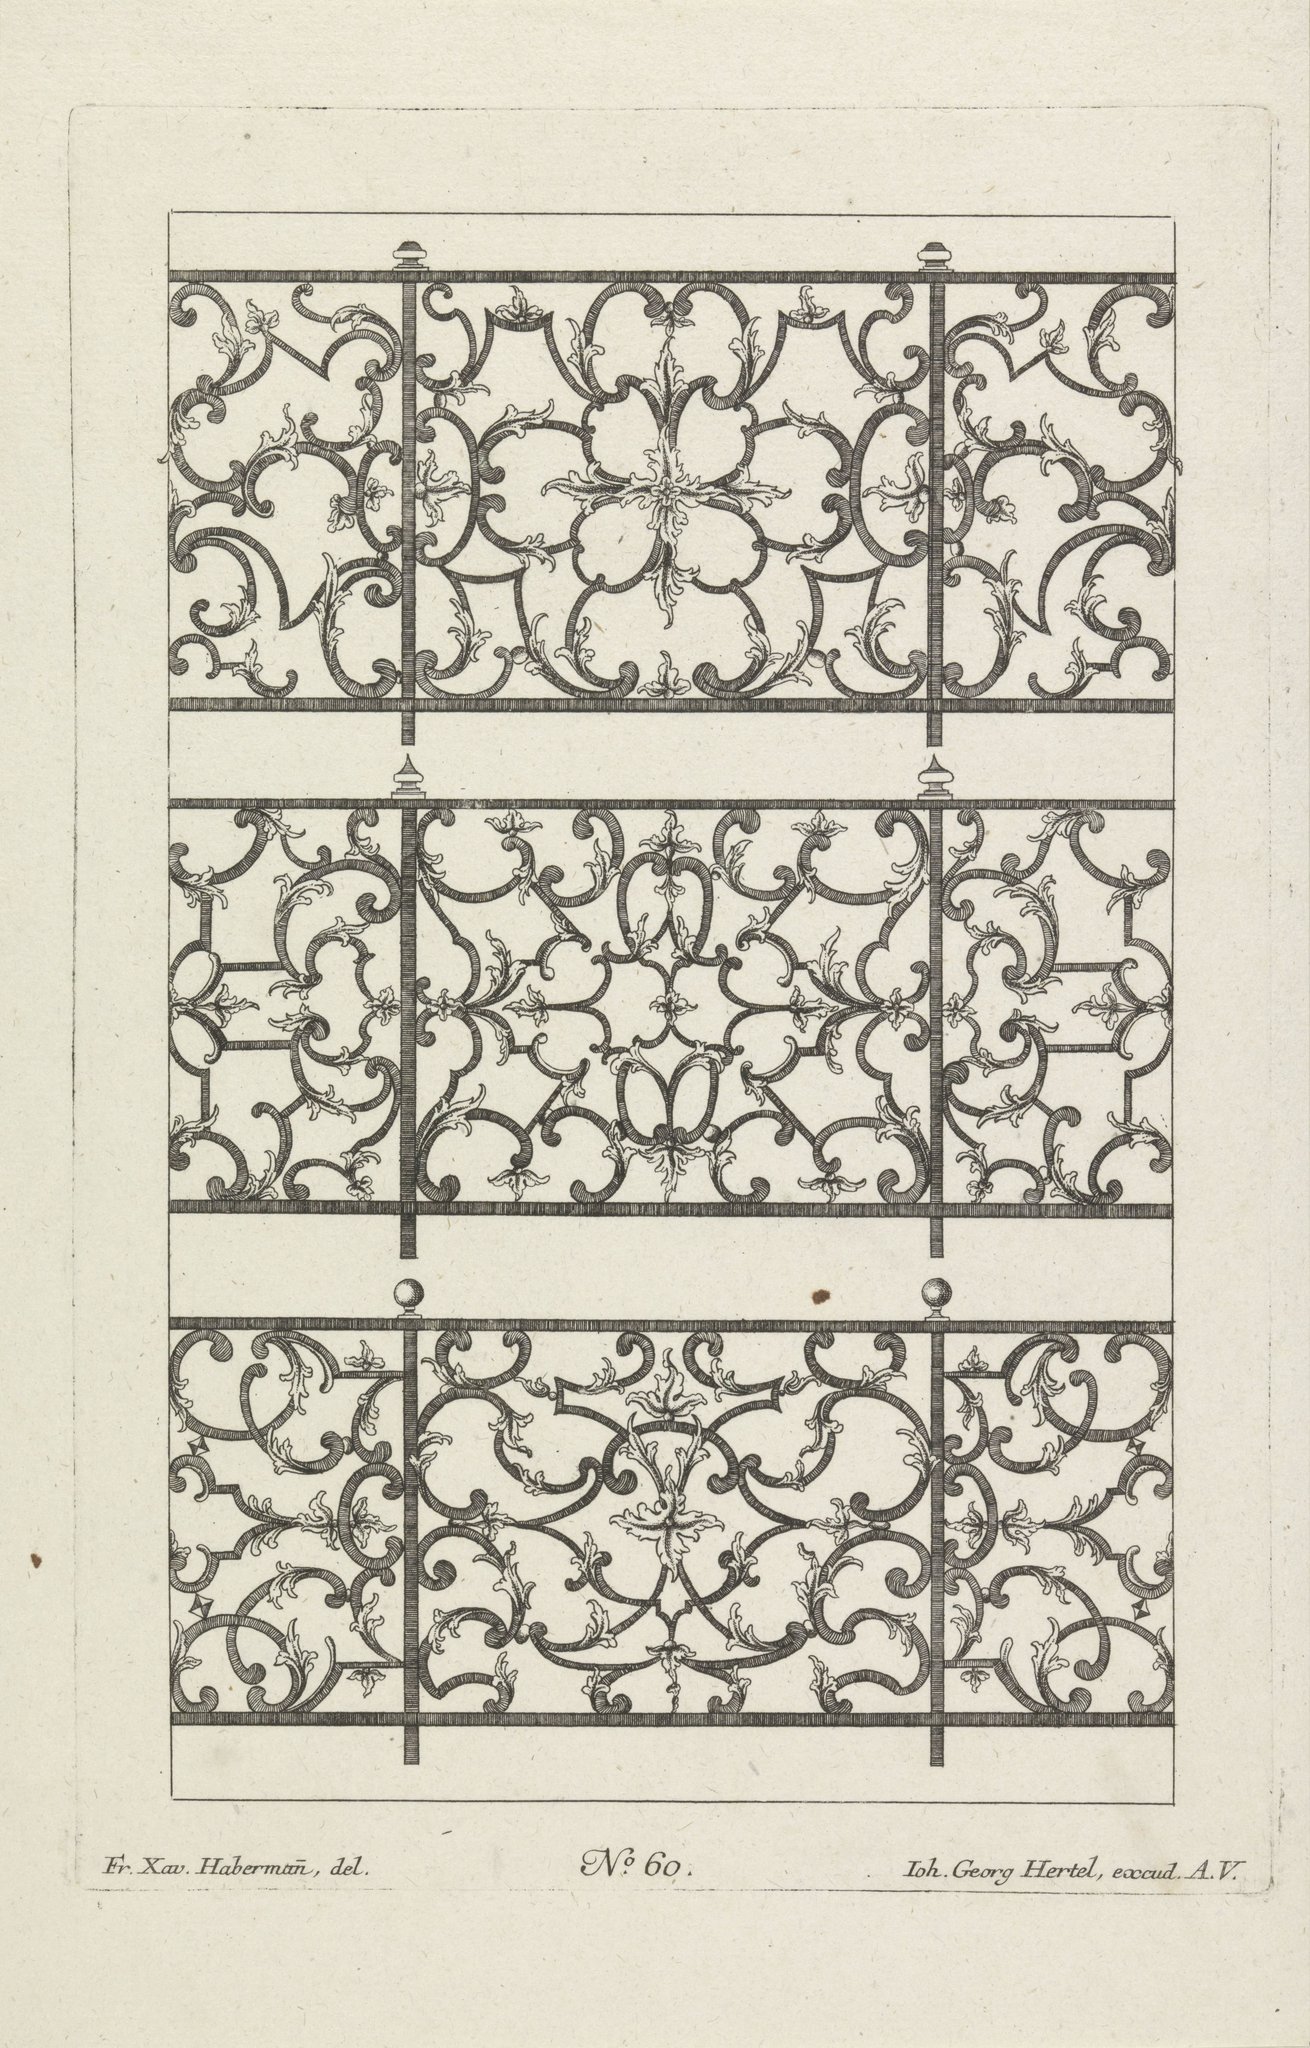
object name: ornament print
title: Ontwerpen voor hekwerken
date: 1731-1775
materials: paper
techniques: etching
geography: augsburg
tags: fence, wall, paling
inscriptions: collector's mark: Lugt 2228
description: Drie hekwerken boven elkaar met bladmotieven. Uitgeversnummer 60.